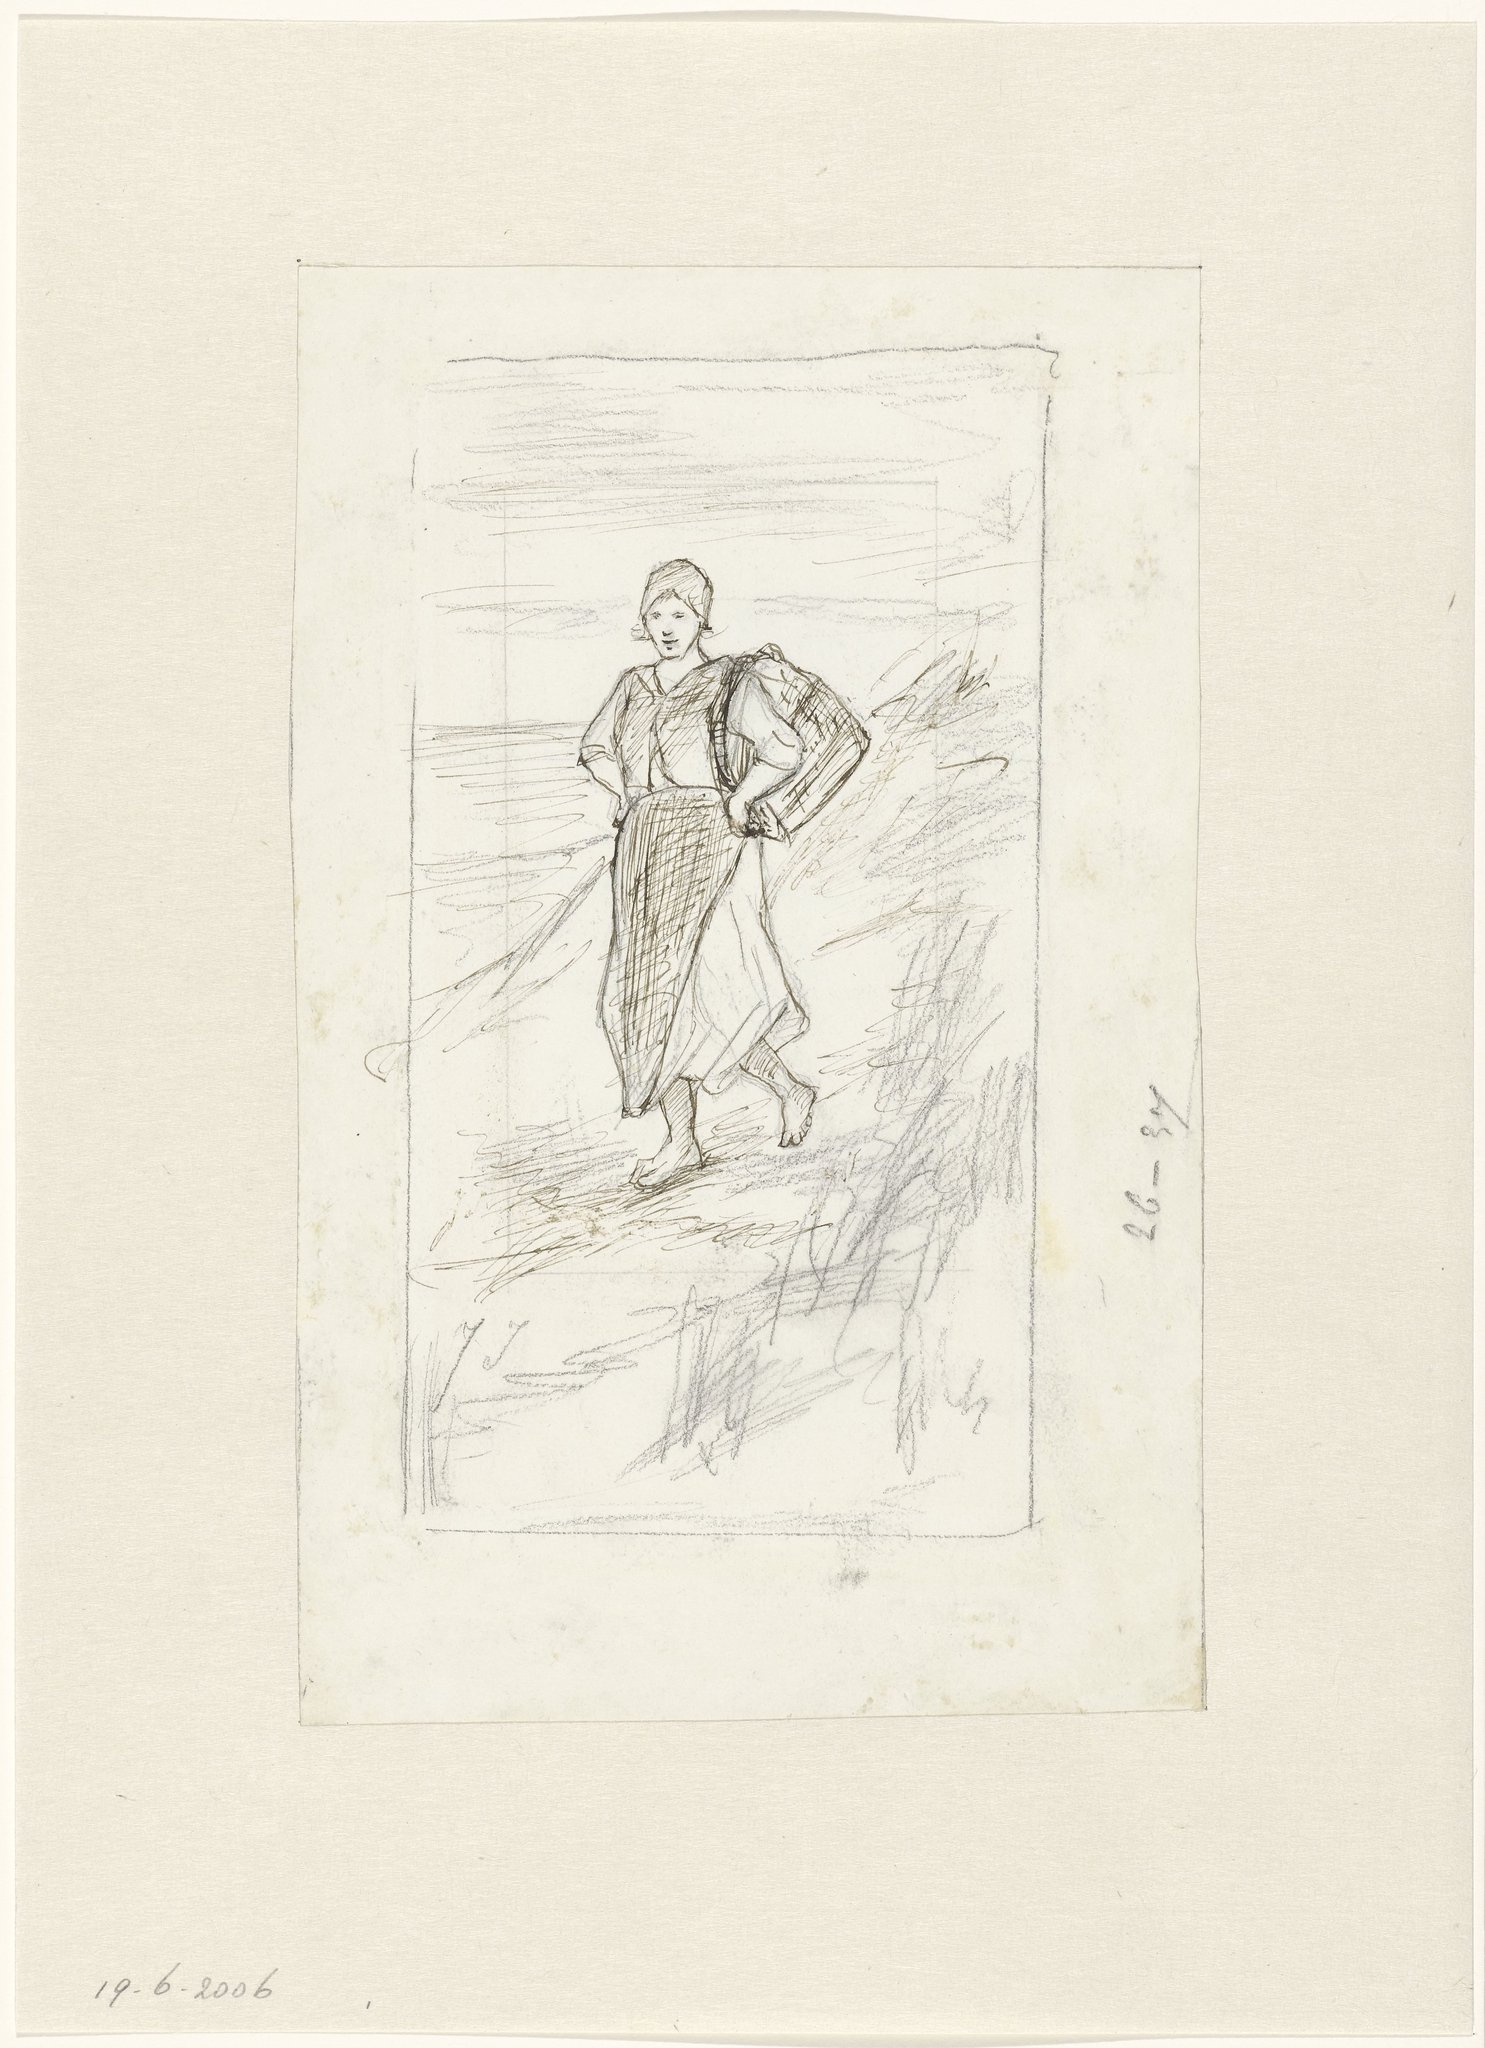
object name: drawing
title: Vissersmeisje, een duin aflopend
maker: jozef israëls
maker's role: draughtsman, painter, print maker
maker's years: 1824-1911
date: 1905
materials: chalk, ink, paper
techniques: pen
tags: beach